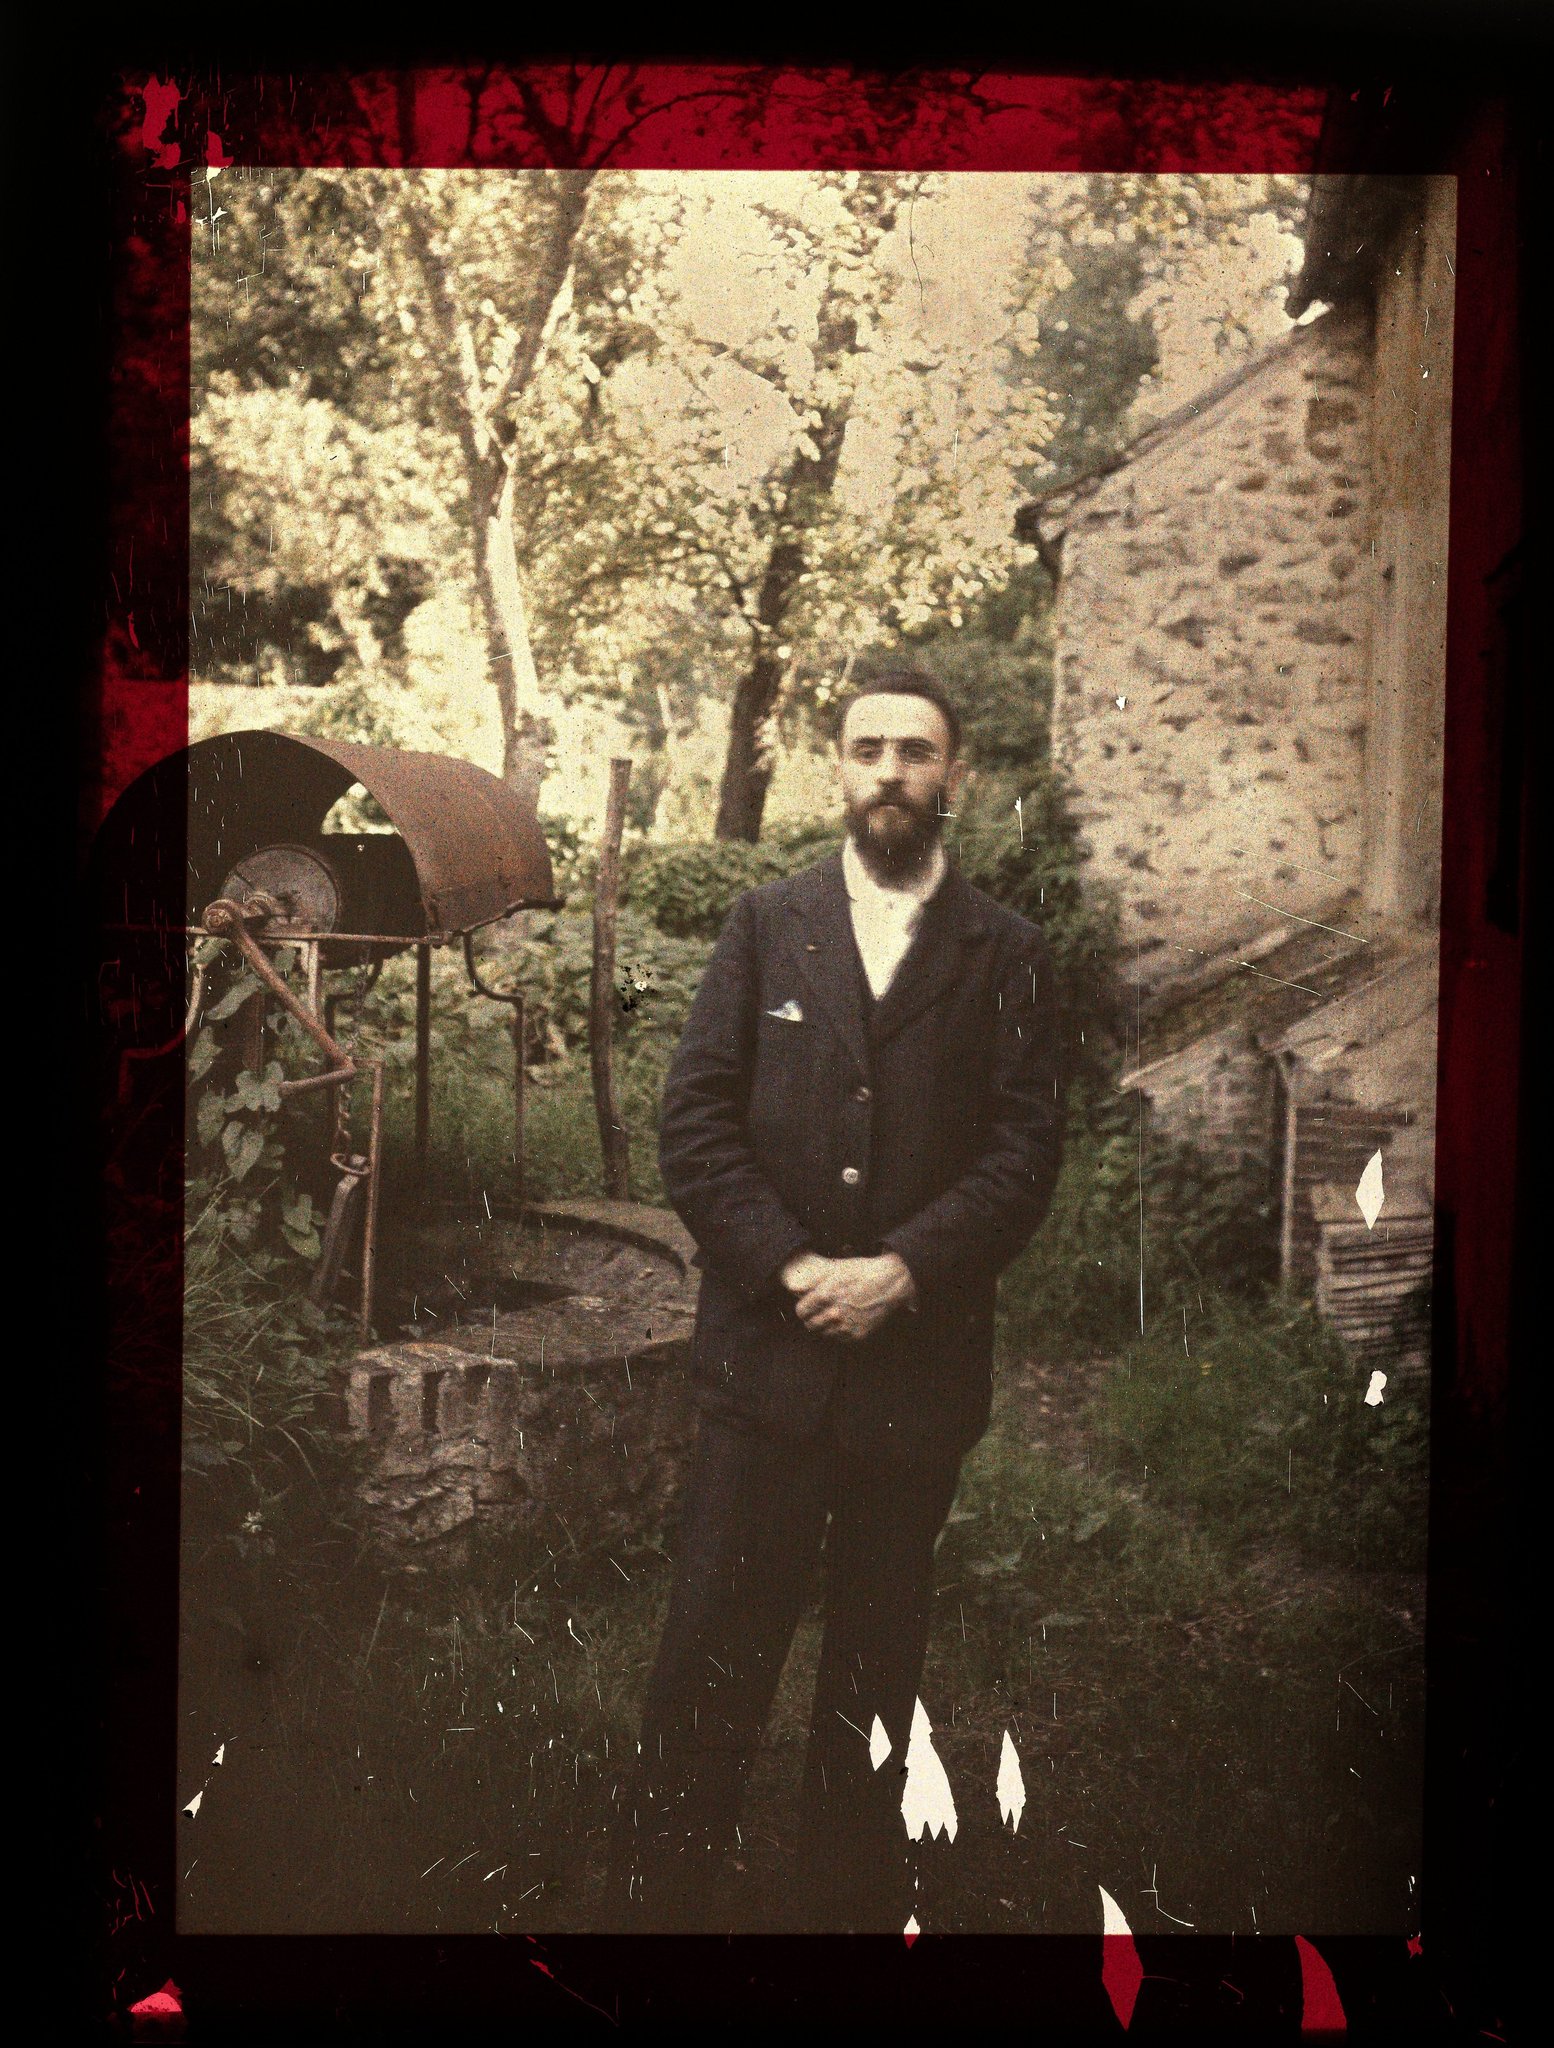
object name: photograph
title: Portret van een onbekende man staand in tuin bij waterput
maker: Anonymous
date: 1907-1930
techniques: autochrome process, slide